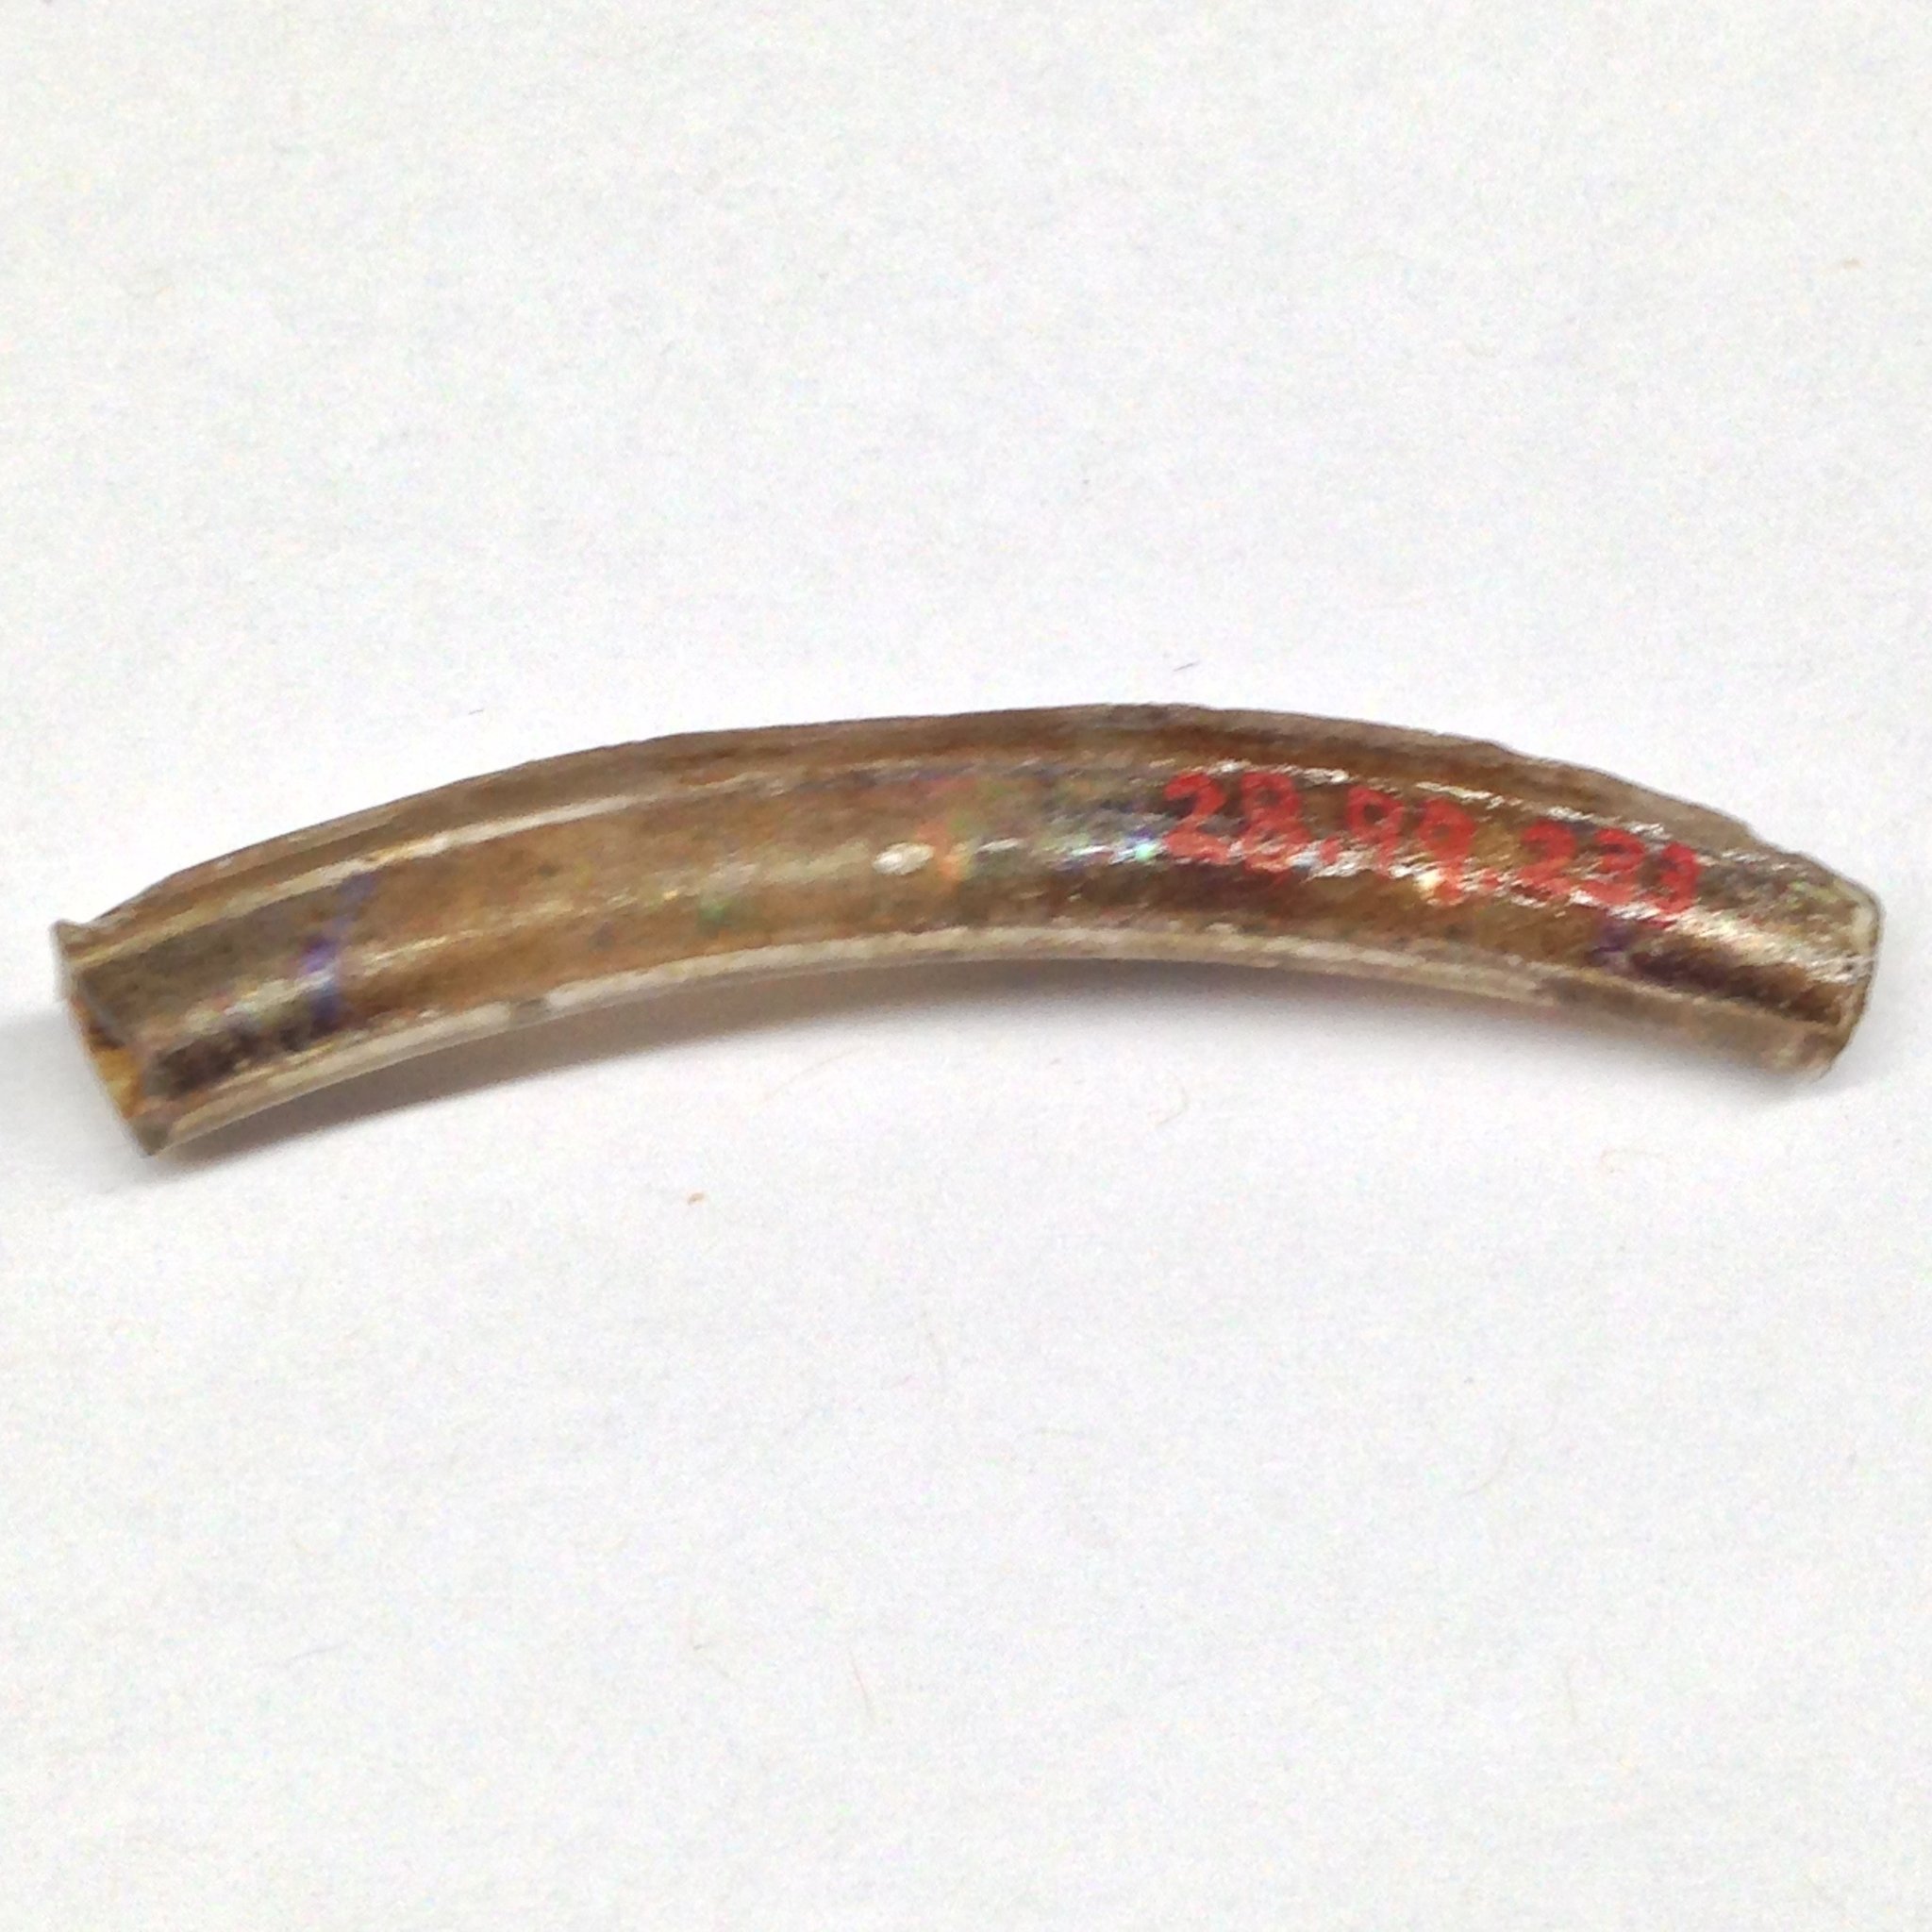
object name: fragment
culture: european or middle eastern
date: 1150-1250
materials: ceramic, glass